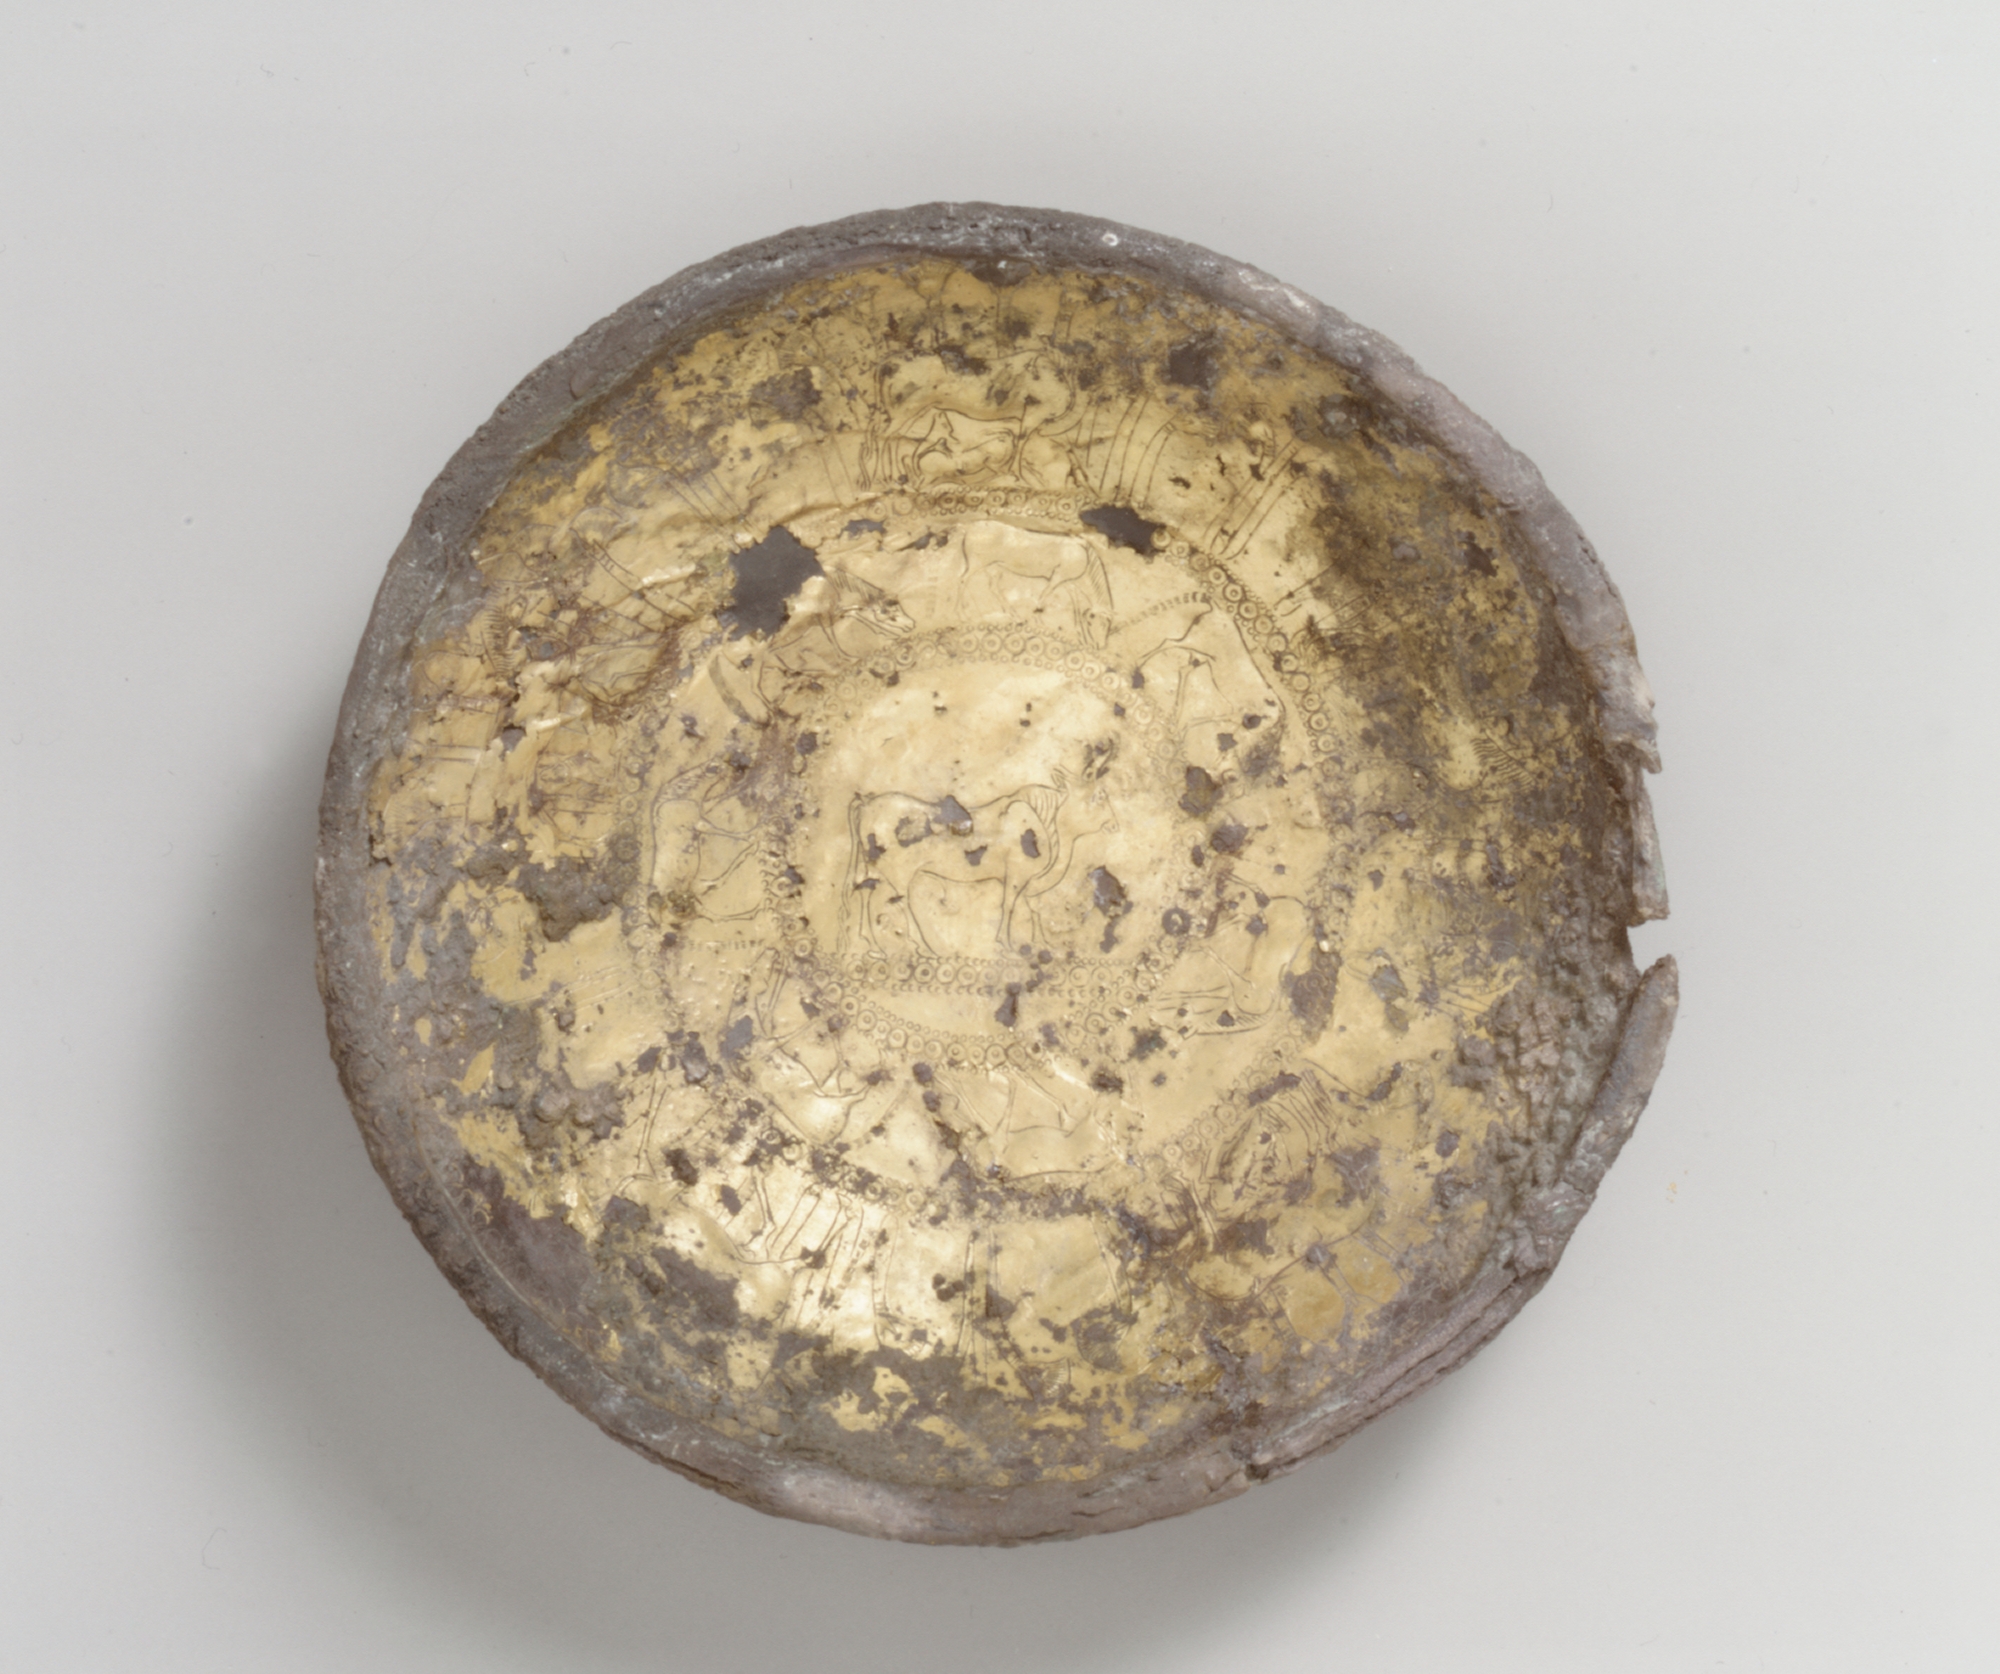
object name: bowl with gilding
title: Silver-gilt bowl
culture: cypriot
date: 710-675 BCE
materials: gold, silver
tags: bulls,cows,horses